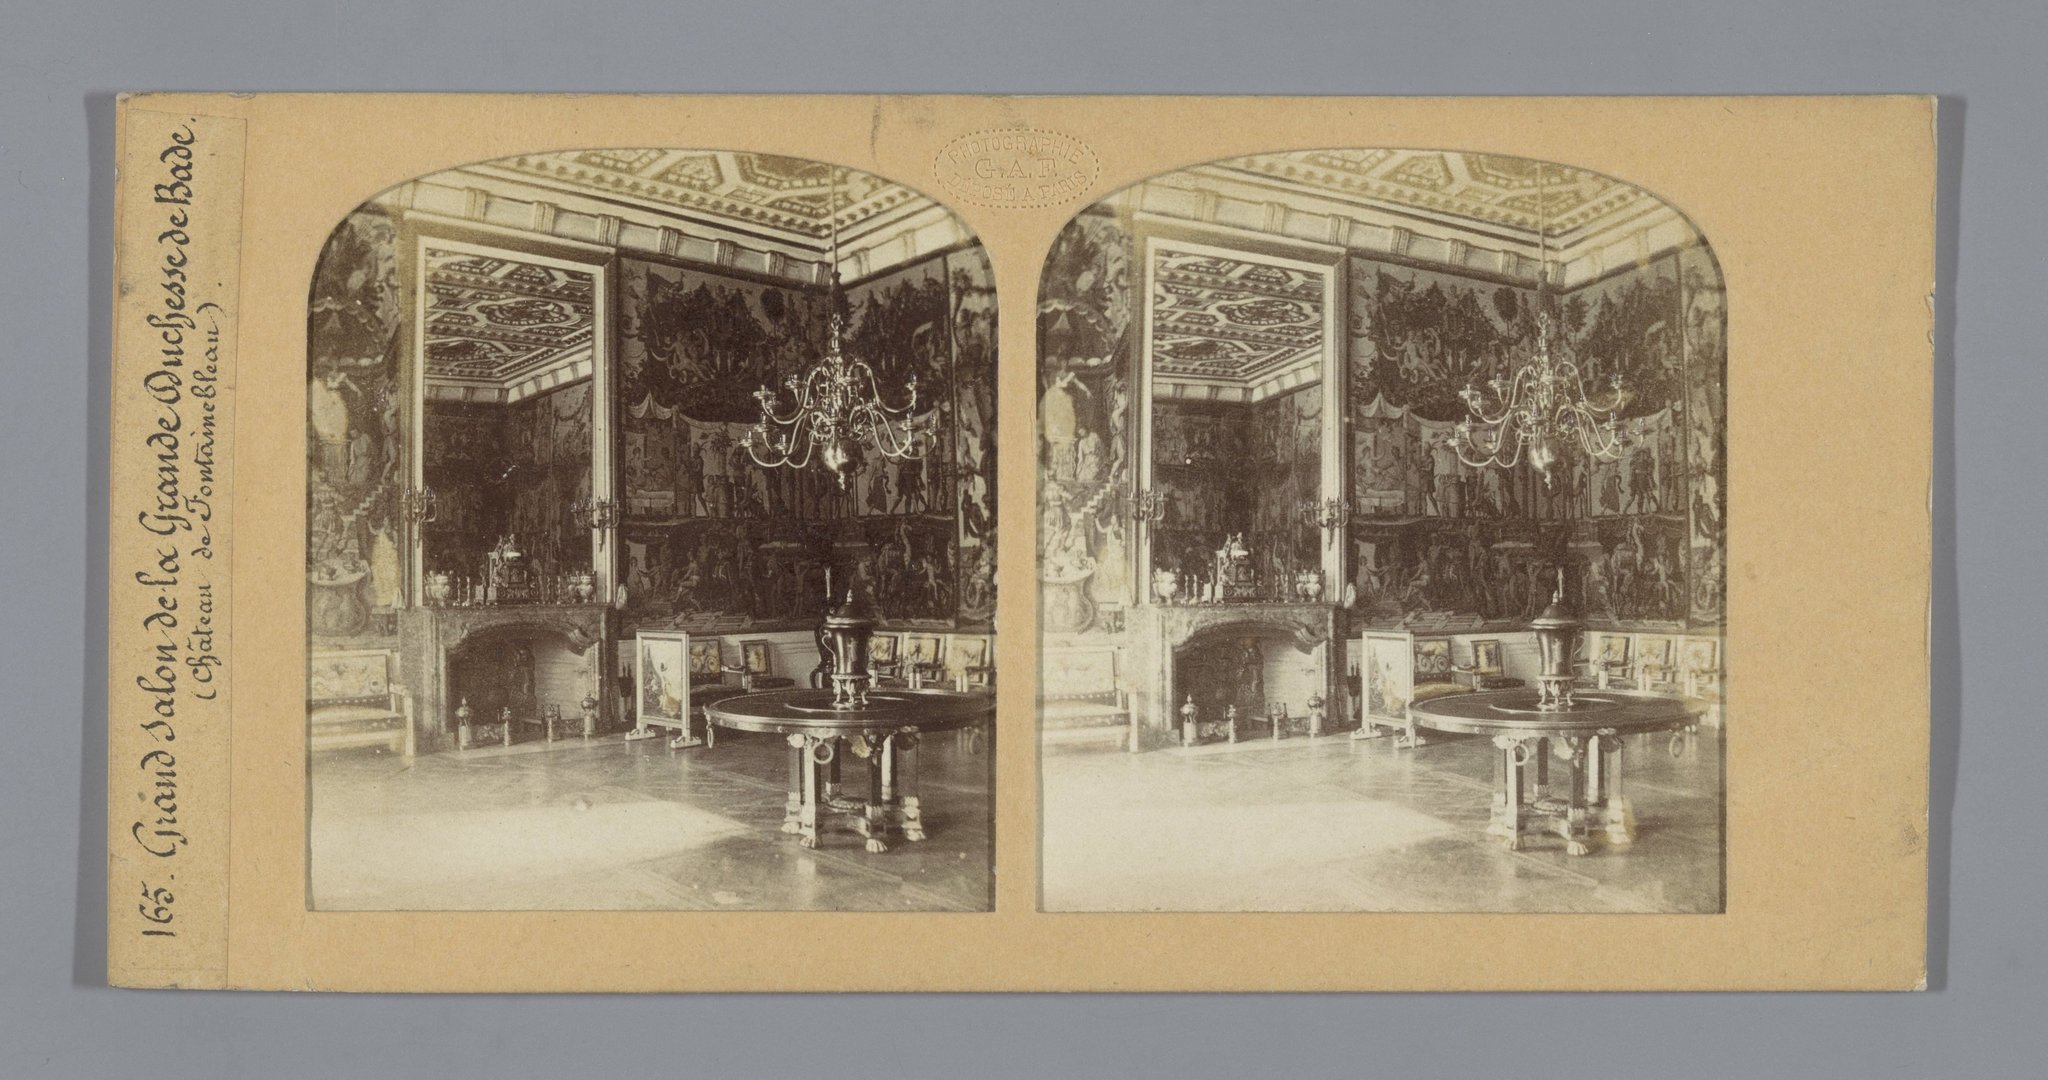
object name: tissue stereograph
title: Grand salon de la Grande Duchesse de Bade (Château de Fontainebleau)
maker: florent grau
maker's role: manufacturer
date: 1858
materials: cardboard, paper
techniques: albumen print, hand coloring, perforating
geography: fontainebleau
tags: drawing-room, 'salon'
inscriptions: inscription: ‘Déposé a Paris’, number: ‘165.’